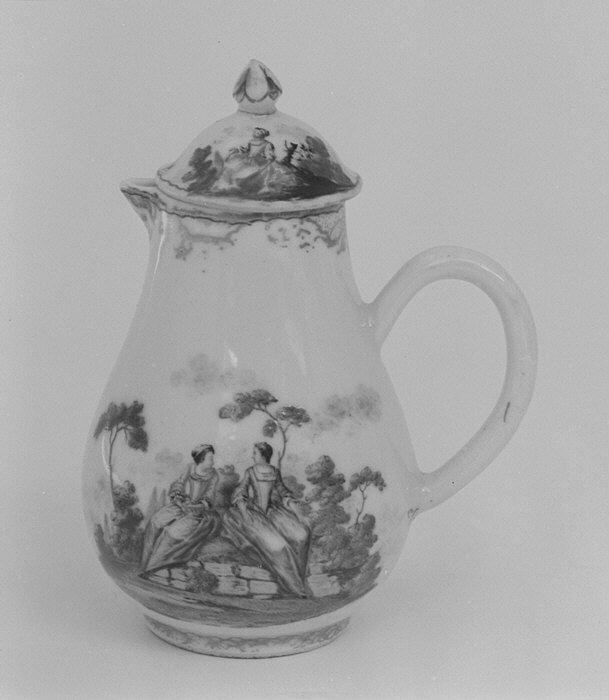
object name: milk jug with cover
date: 1760-1780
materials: hard paste porcelain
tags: women